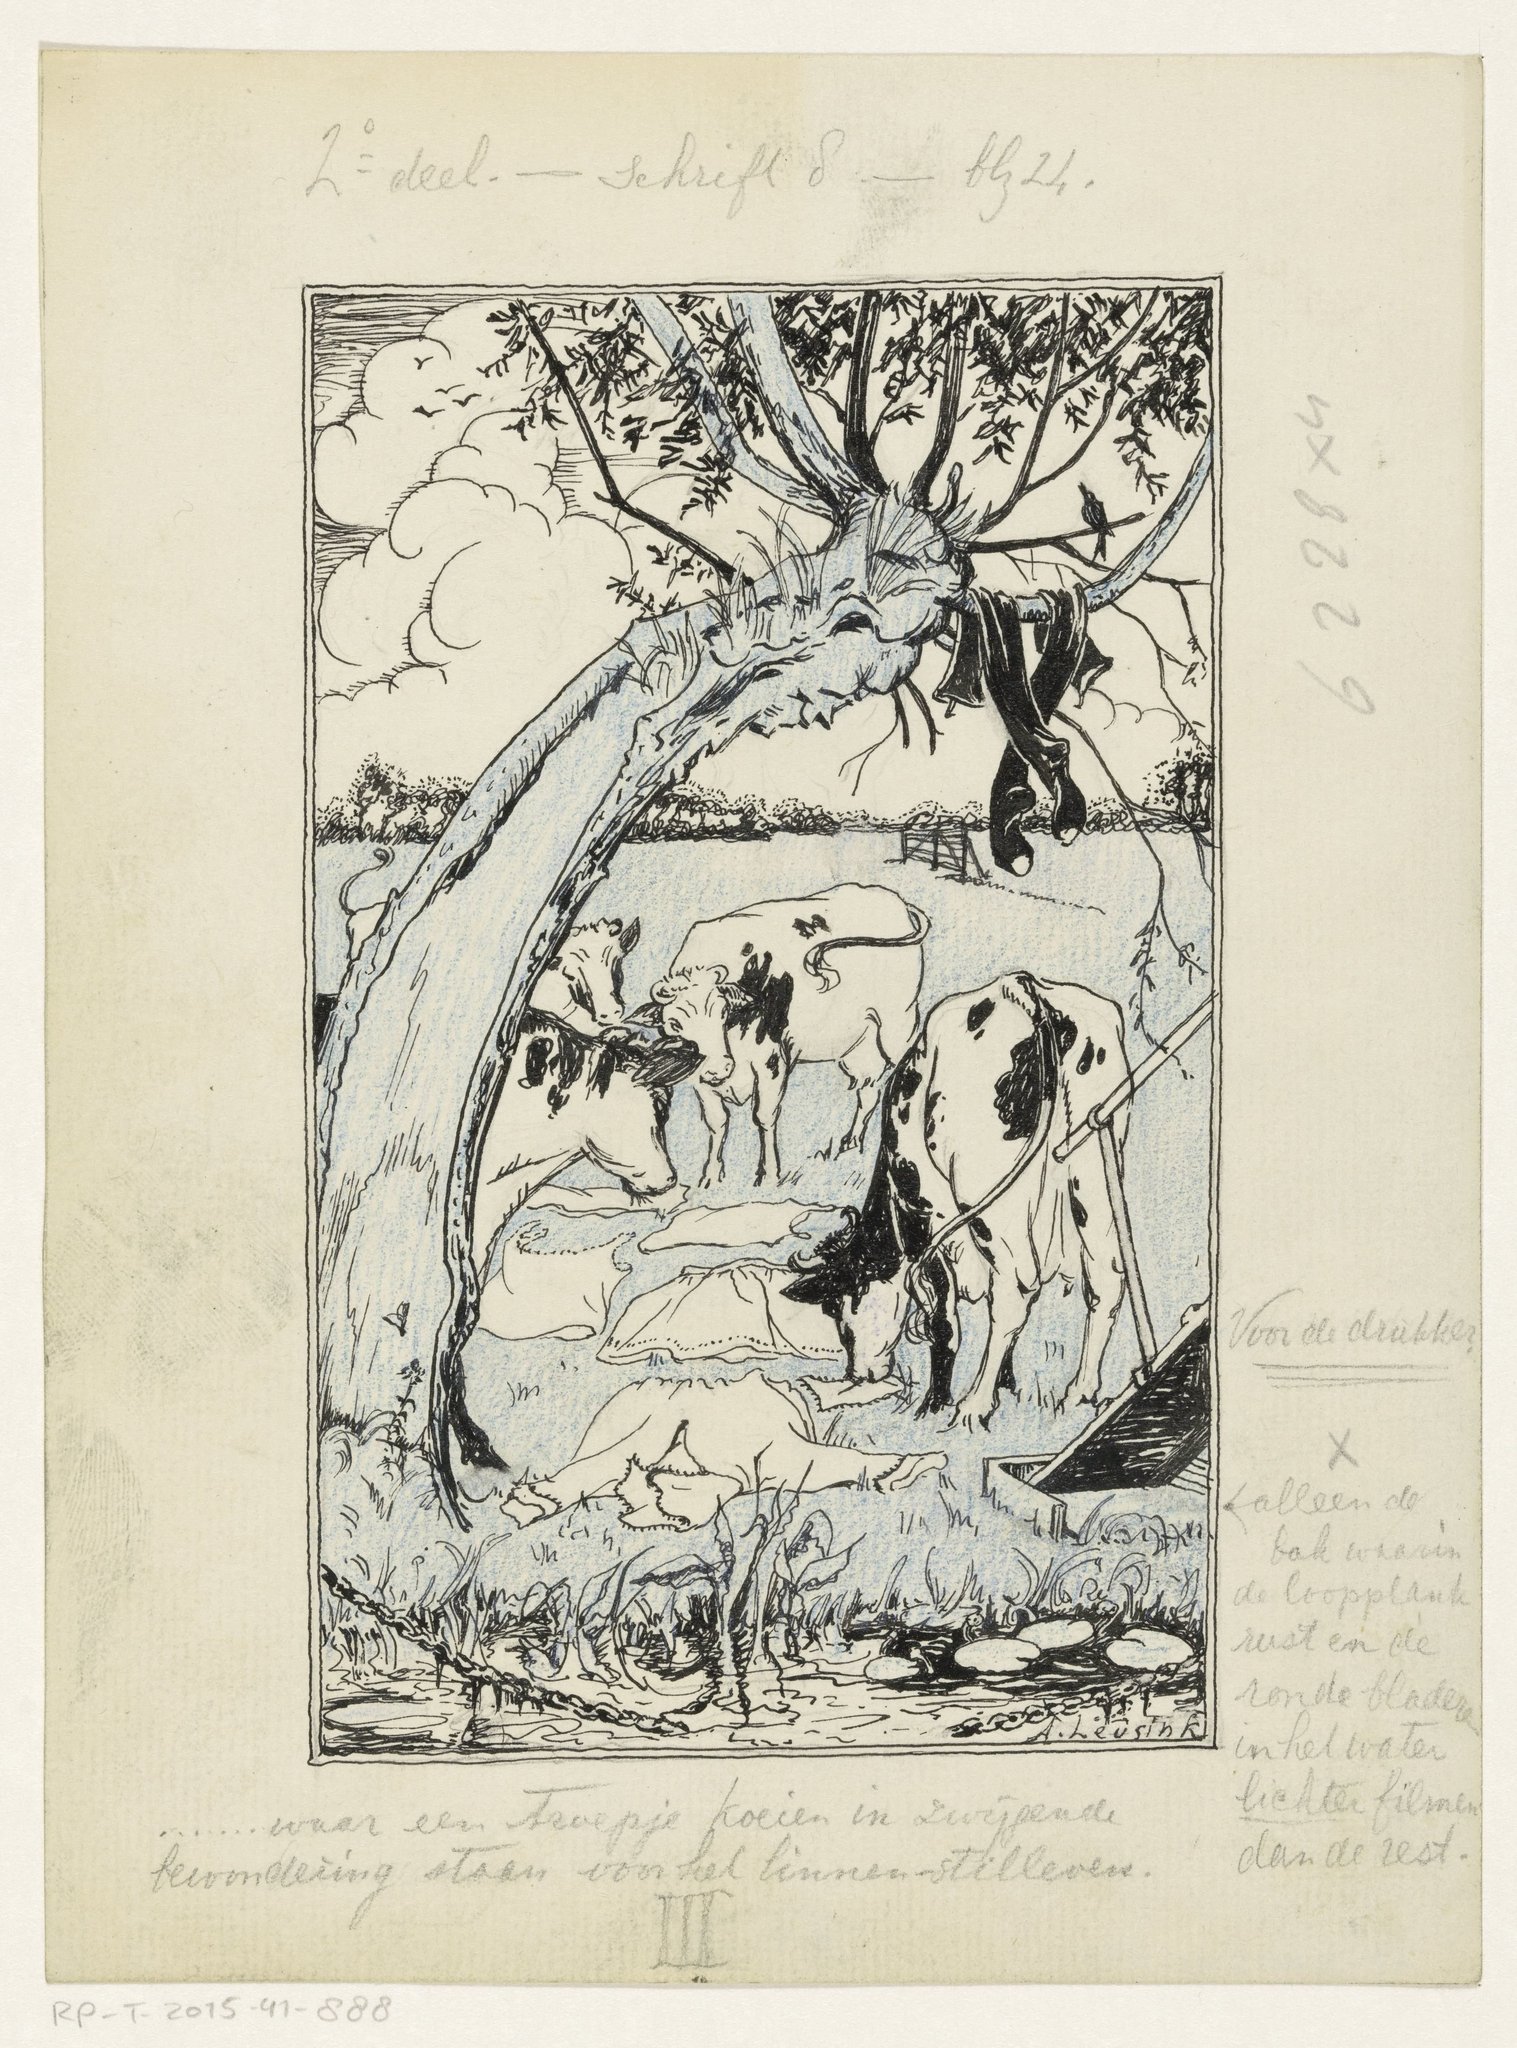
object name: boekillustratie ontwerp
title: Koeien tussen het wasgoed in een weiland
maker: anny leusink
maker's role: draughtsman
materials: ink, paper, pencil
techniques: pen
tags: cow, drying, being dried - aa - in the open air, meadow, pasture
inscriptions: collector's mark: Lugt 2228, signature: ‘A. Leusink’, annotation: ‘2e deel. _ schrift 8. _ blz 24./ ... waar een troepje koeien in zwijgende/ bewondering staan voor het linnen-stilleven./ III’, :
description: Vier koeien staan aan een waterkant en kijken naar verschillende kledingstukken die in het weiland liggen. In de boom aan de waterkant hangt ook een paar kousen. Een loopplank verbindt een boot met de waterkant.